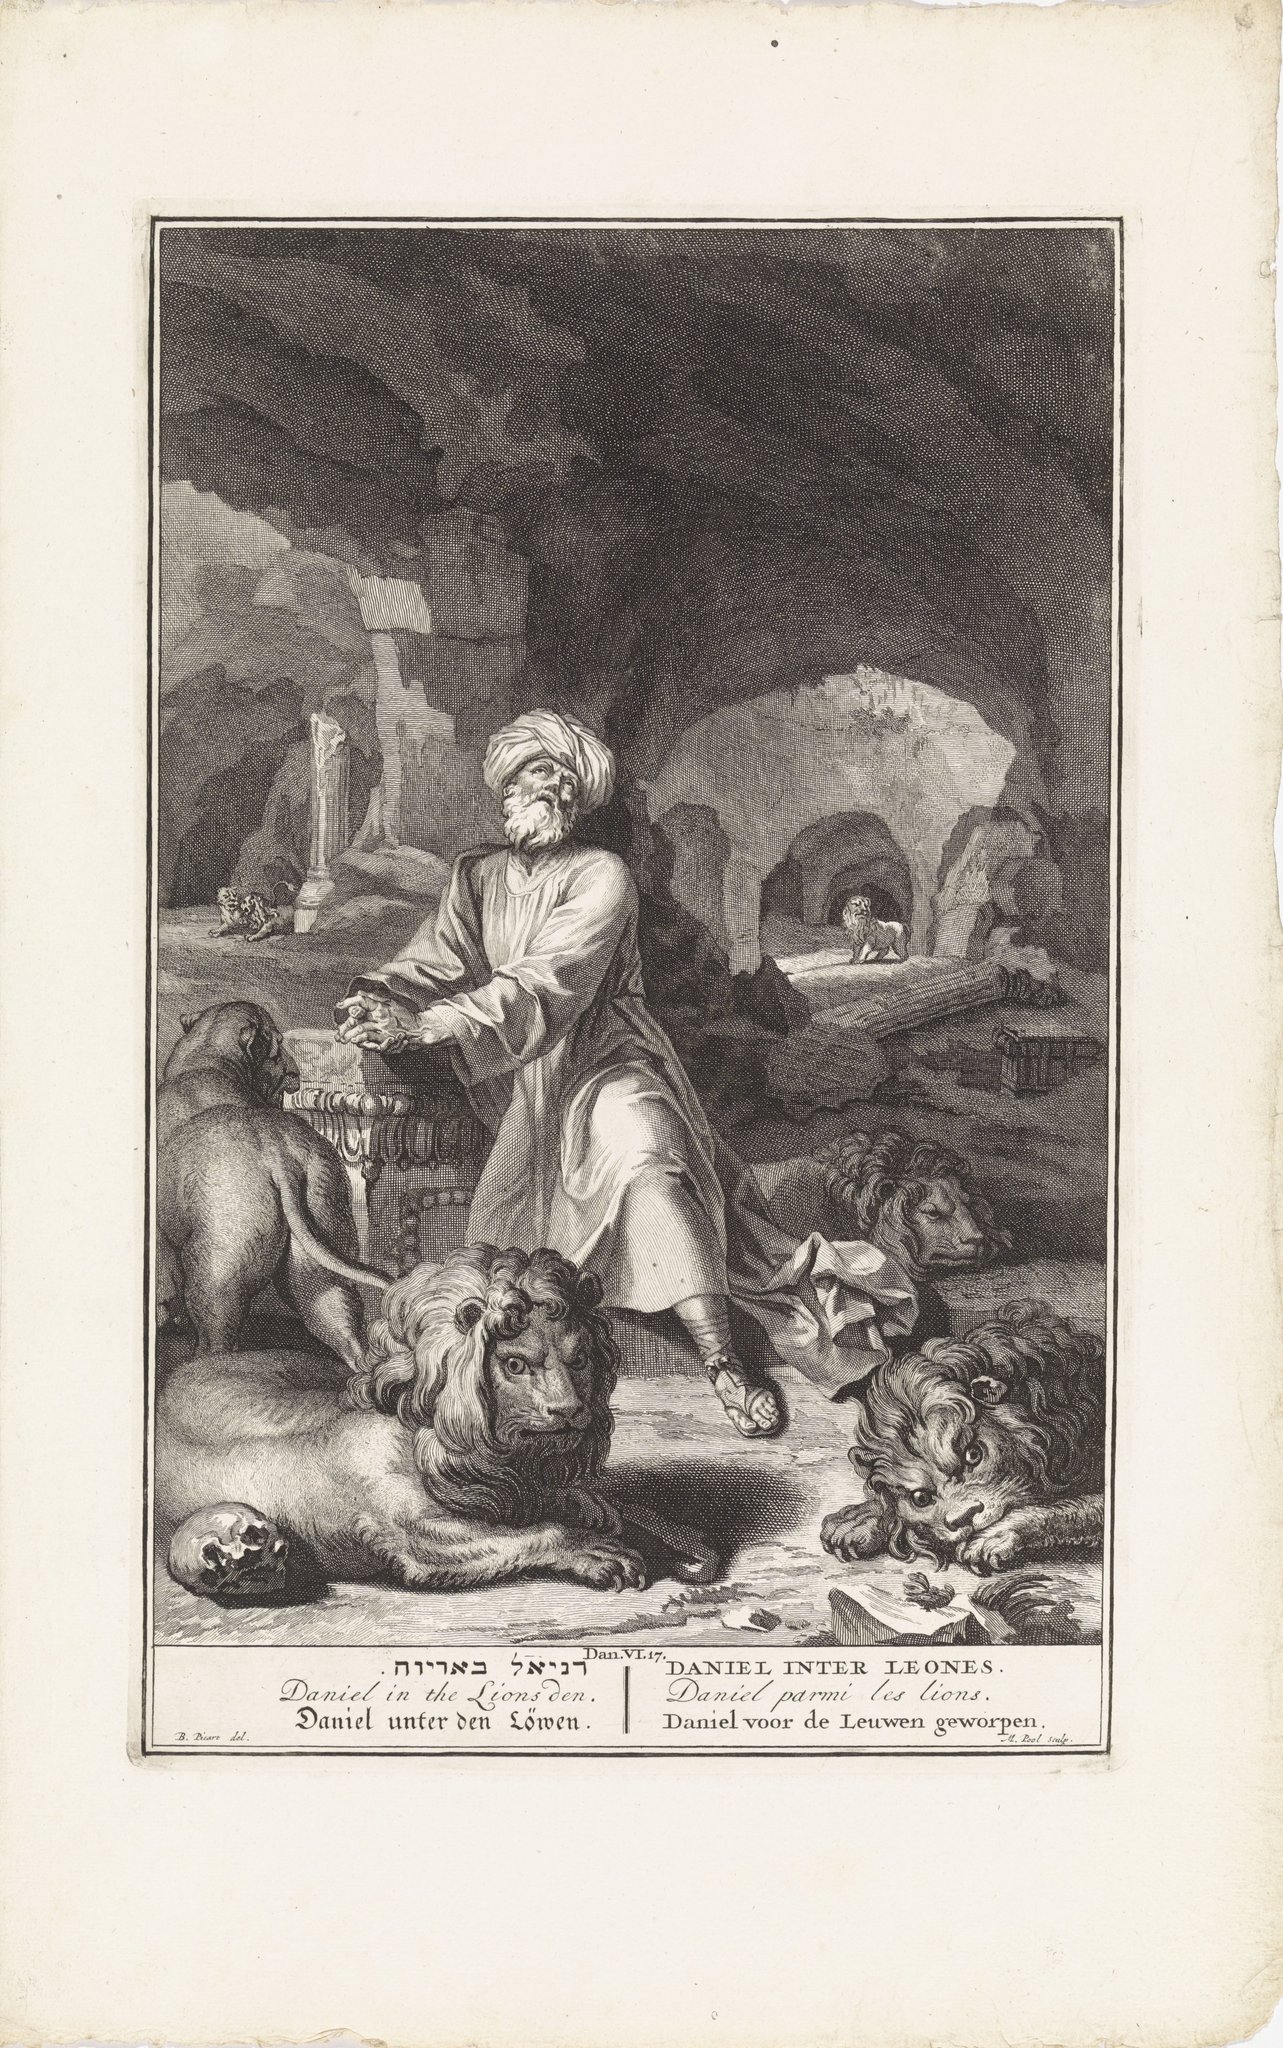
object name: book illustration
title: Daniël in de leeuwenkuil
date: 1705-1720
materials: paper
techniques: engraving, etching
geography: amsterdam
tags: daniel's punishment and liberation: daniel in the lion's den ~ king darius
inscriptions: inscription: ‘Utrechts Fundatie huijs’, collector's mark: Lugt 2228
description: Prent oorspronkelijk bedoeld voor: Figures de la Bible. Amsterdam: Bernard Picart, 1720. Prent ook gebruikt in: Taferelen der voornaamste geschiedenissen van het Oude en Nieuwe Testament (...) door de vermaarde kunstenaars Hoet, Houbraken, en Picart getekent (...) en met beschrijvingen uitgebreid. Den Haag: Pieter de Hondt, 1728.